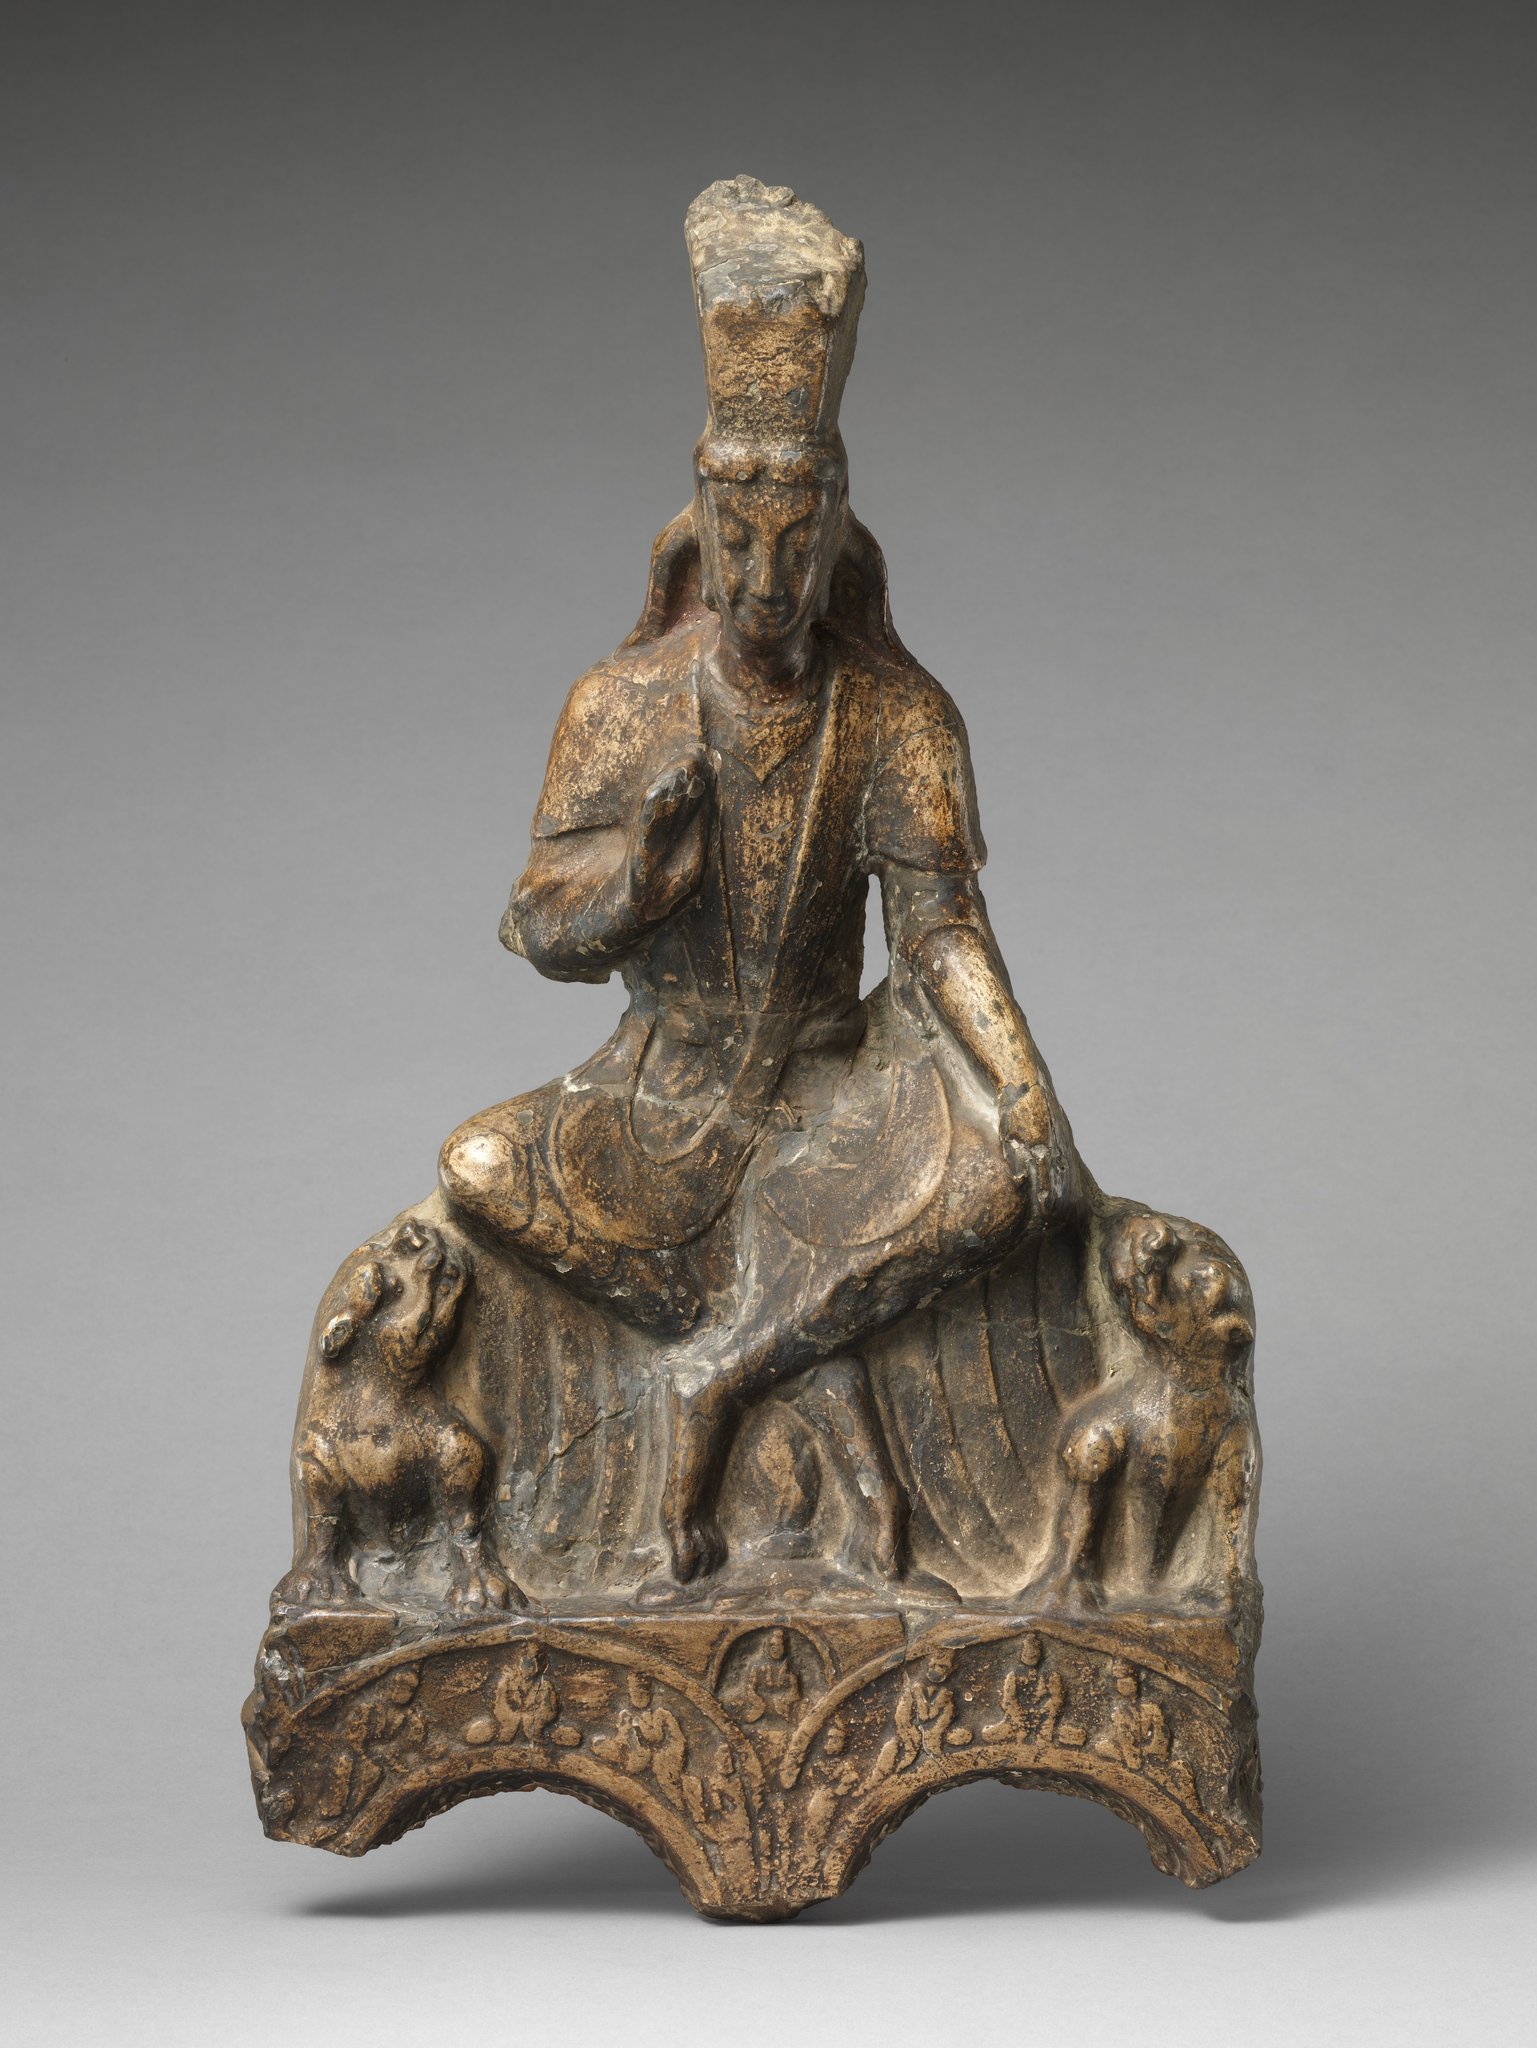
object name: figure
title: Bodhisattva, possibly Maitreya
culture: chinese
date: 501-533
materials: limestone